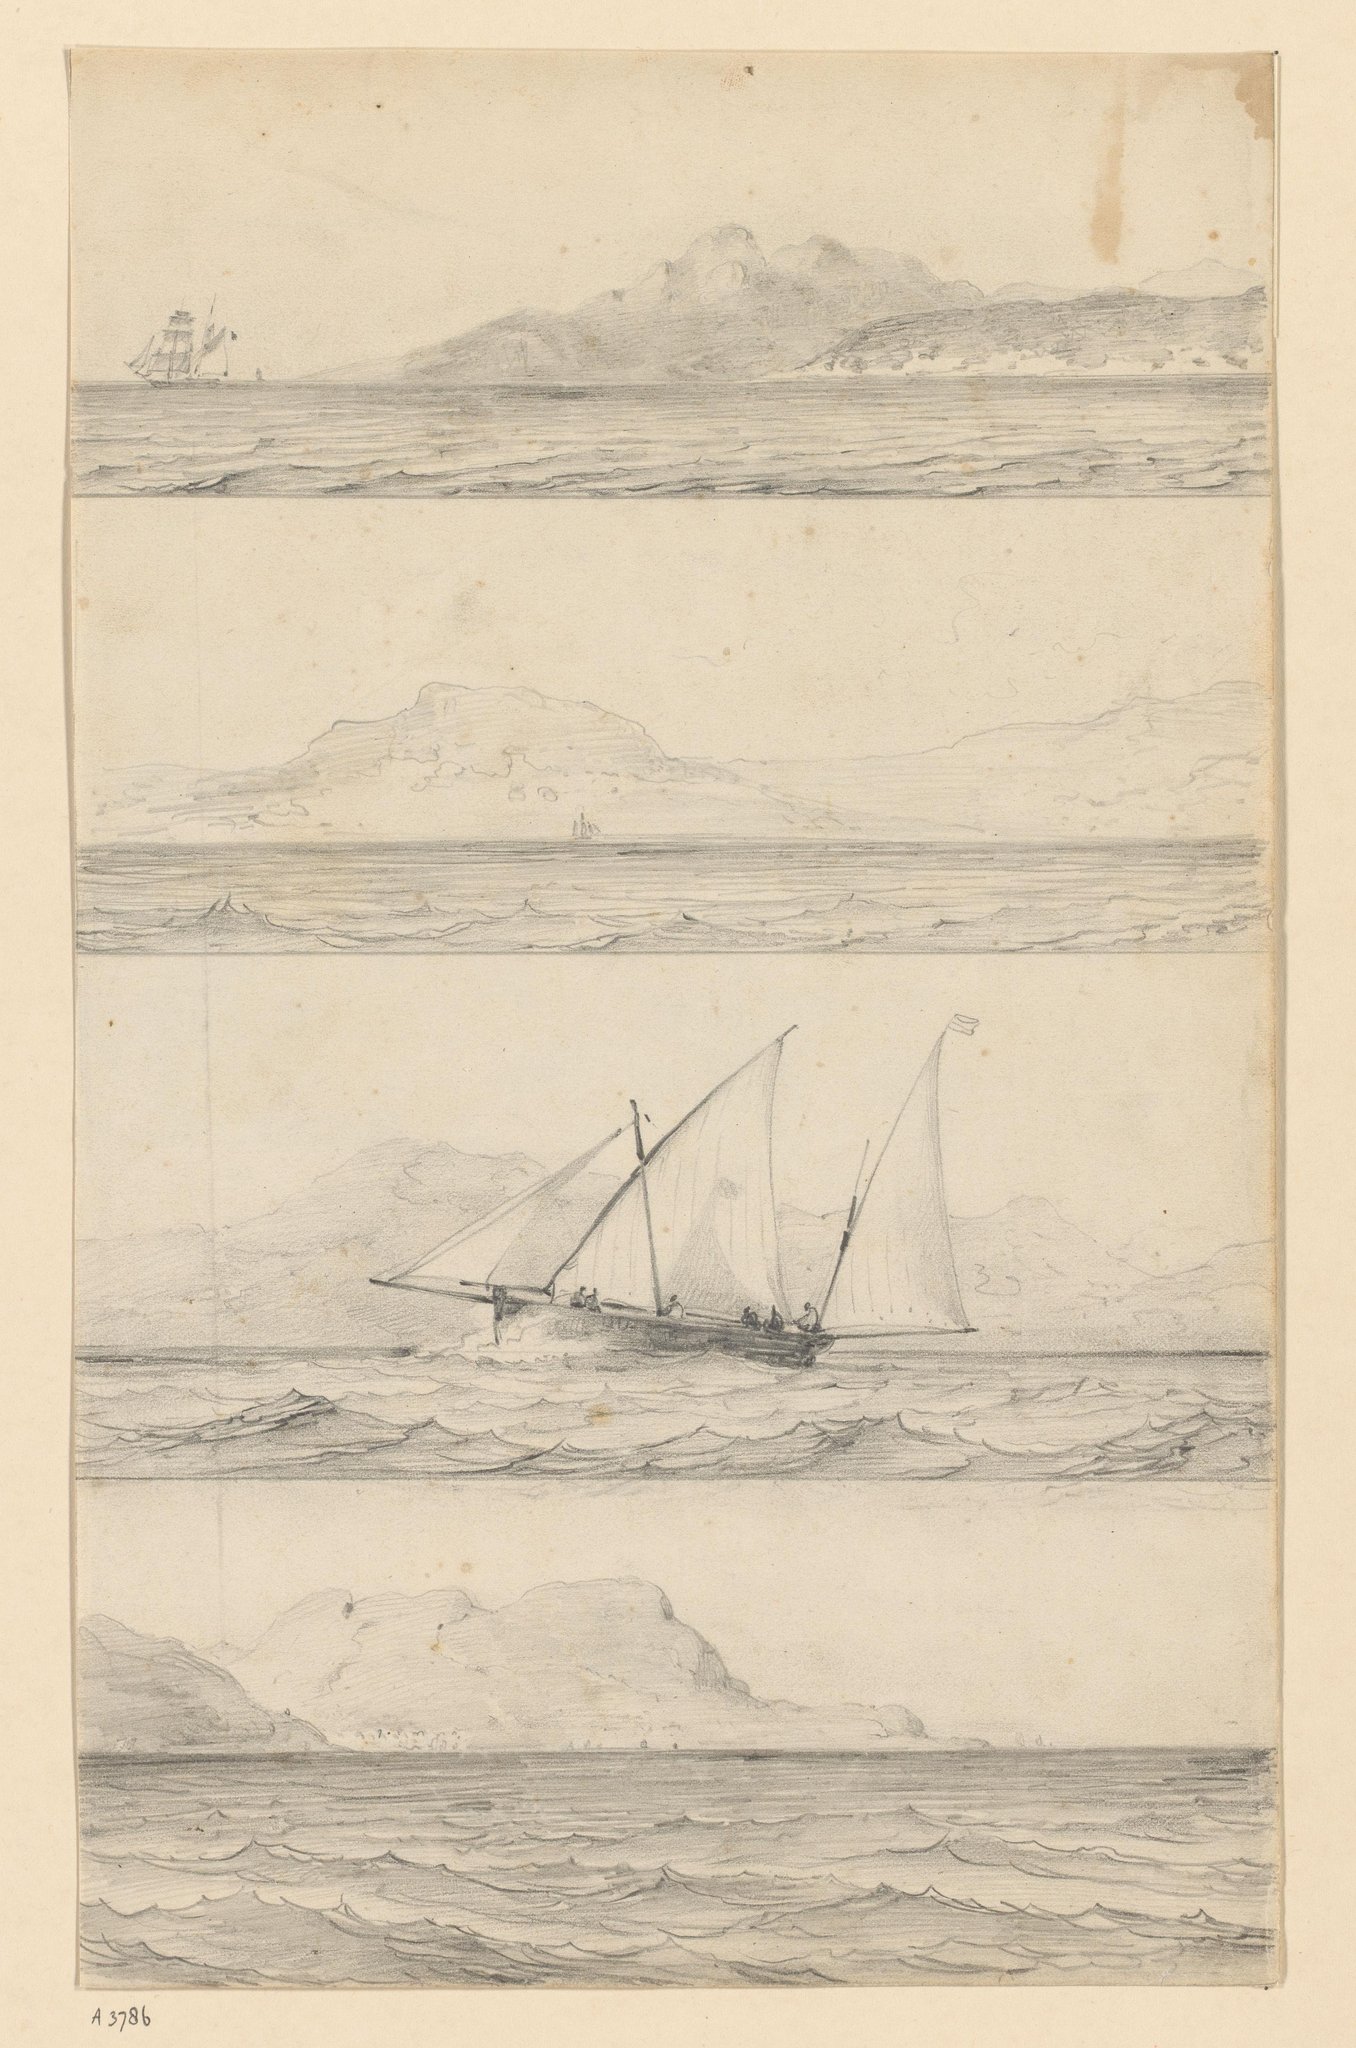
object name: drawing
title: Vier studies van Gibraltar gezien vanaf een schip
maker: willem anthonie van deventer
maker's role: draughtsman, painter, print maker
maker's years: 1824-1893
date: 1834-1893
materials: paper, pencil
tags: city-view, and landscape with man-made constructions